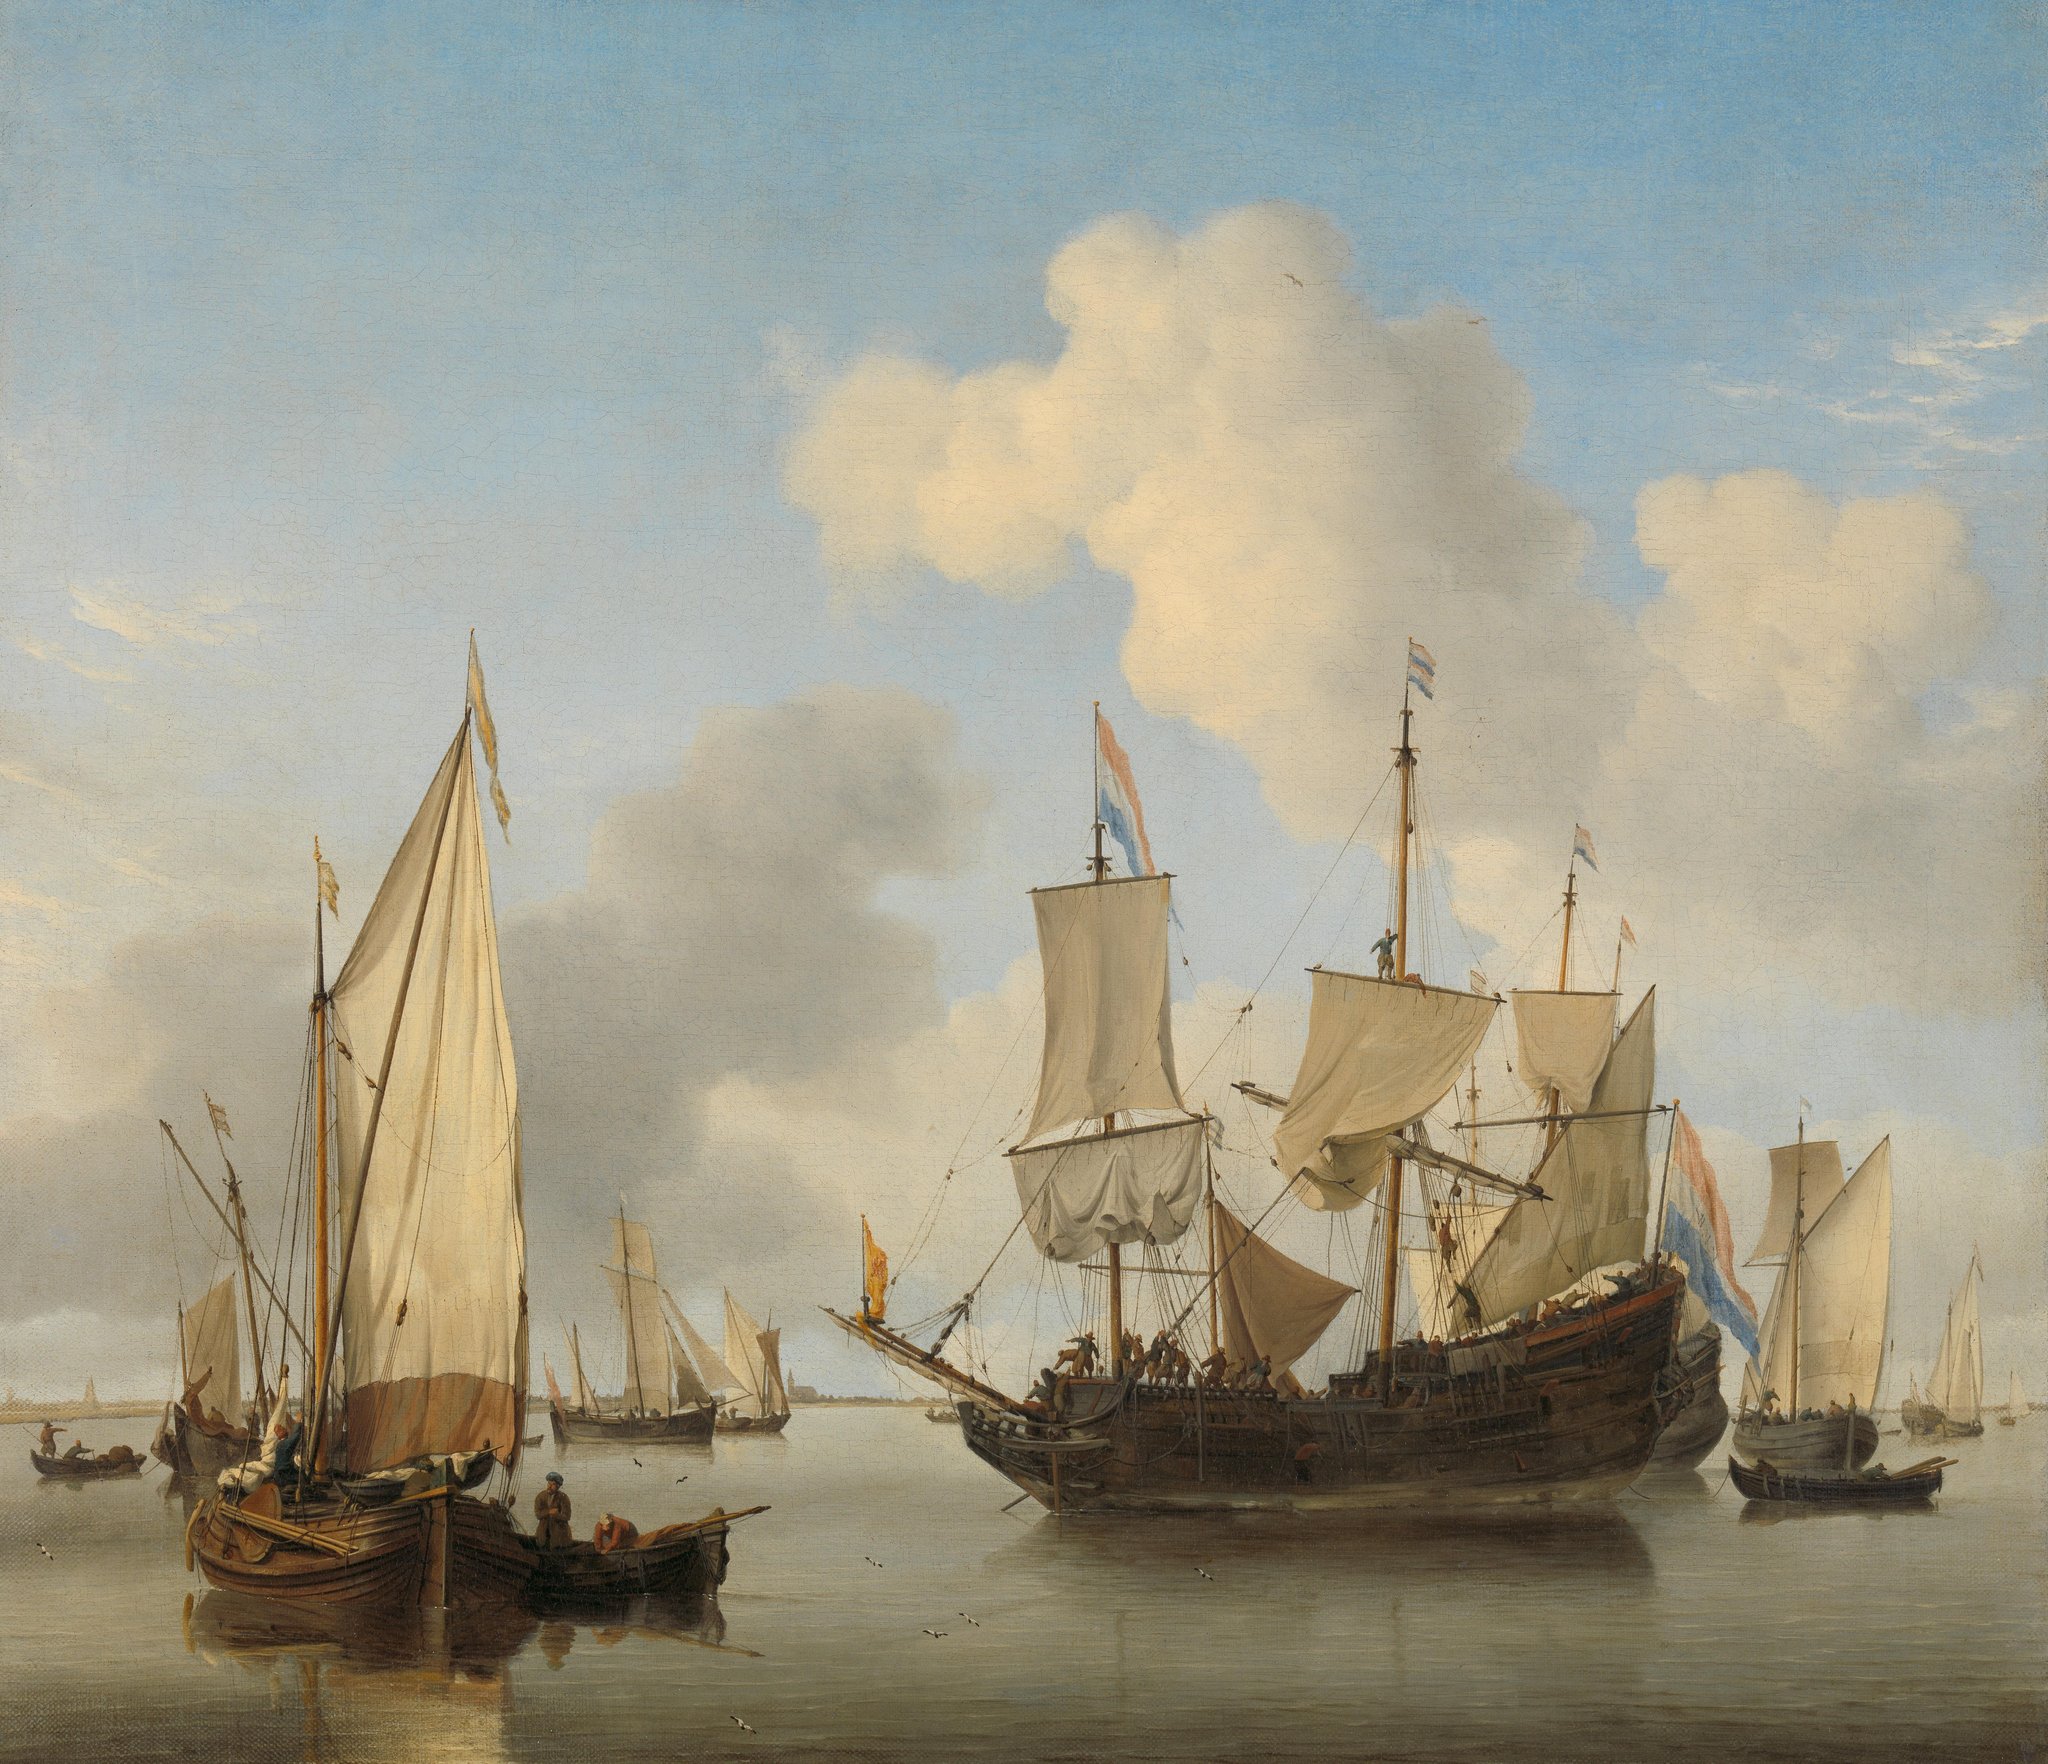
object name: painting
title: Ships at Anchor on the Coast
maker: willem van de velde (ii)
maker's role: draughtsman, painter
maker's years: 1633-1707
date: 1660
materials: canvas, oil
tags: sailing-ship, sailing-boat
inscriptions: signature: ‘W.V.V.’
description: Schepen onder de kust voor anker, met op de voorgrond een admiraliteitsschip met op de witte baan van de Nederlandse vlag op het achterschip de initialen ('W.v.V.') van de schilder. Daarachter een fluitschip. Links en rechts kleine vrachtschepen, een spiegeljacht en roeiboten.